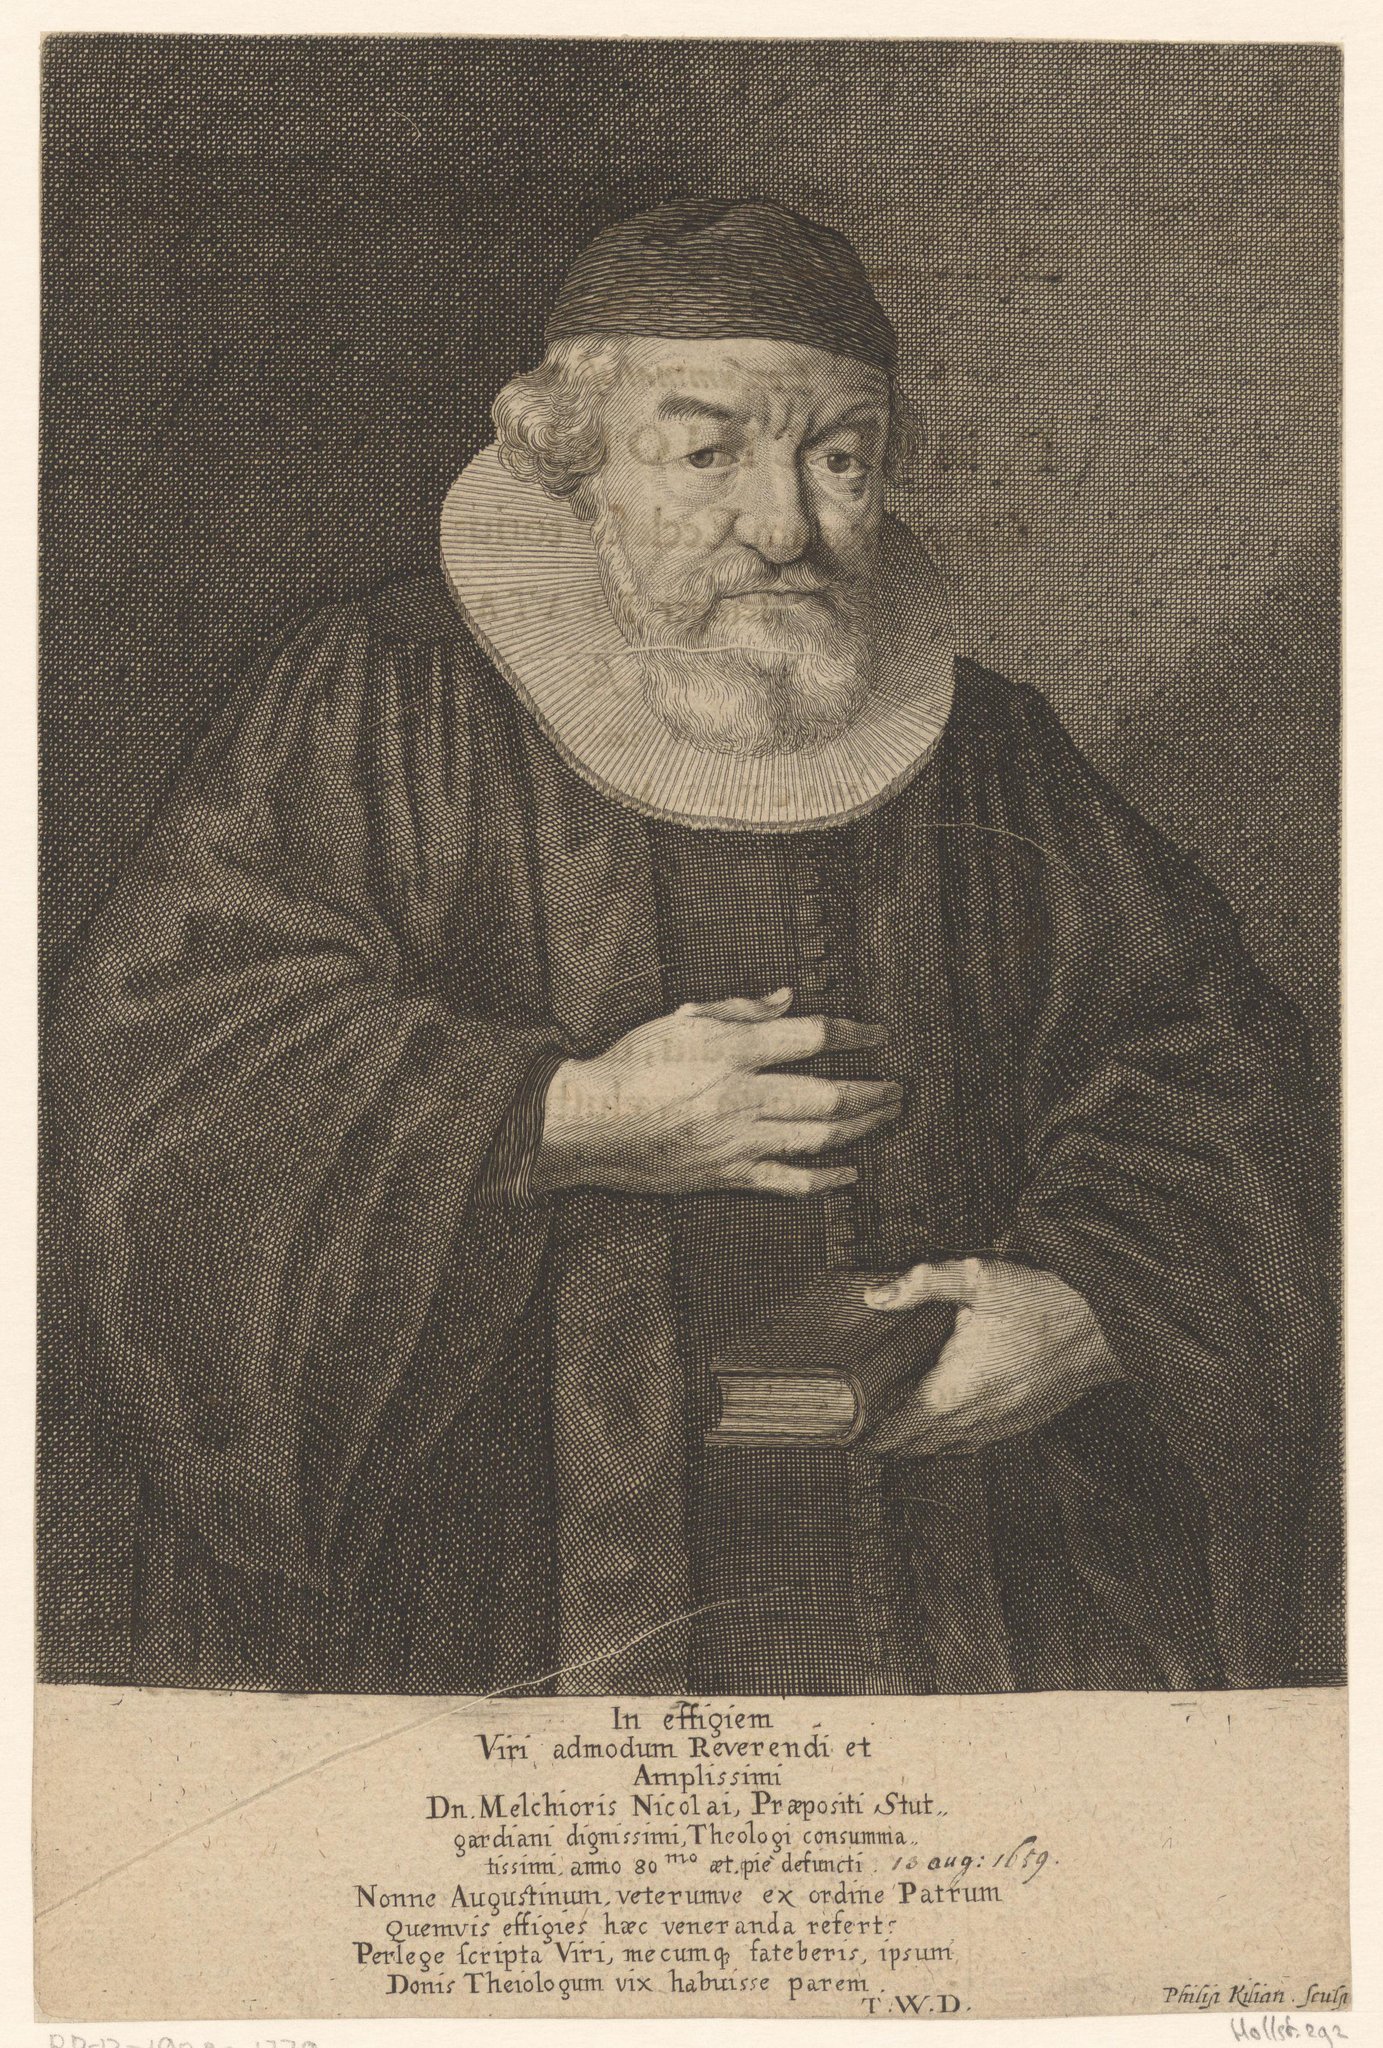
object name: print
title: Portret van Melchior Nicolai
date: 1659-1693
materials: paper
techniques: engraving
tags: theologian, historical persons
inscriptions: collector's mark: Lugt 2228